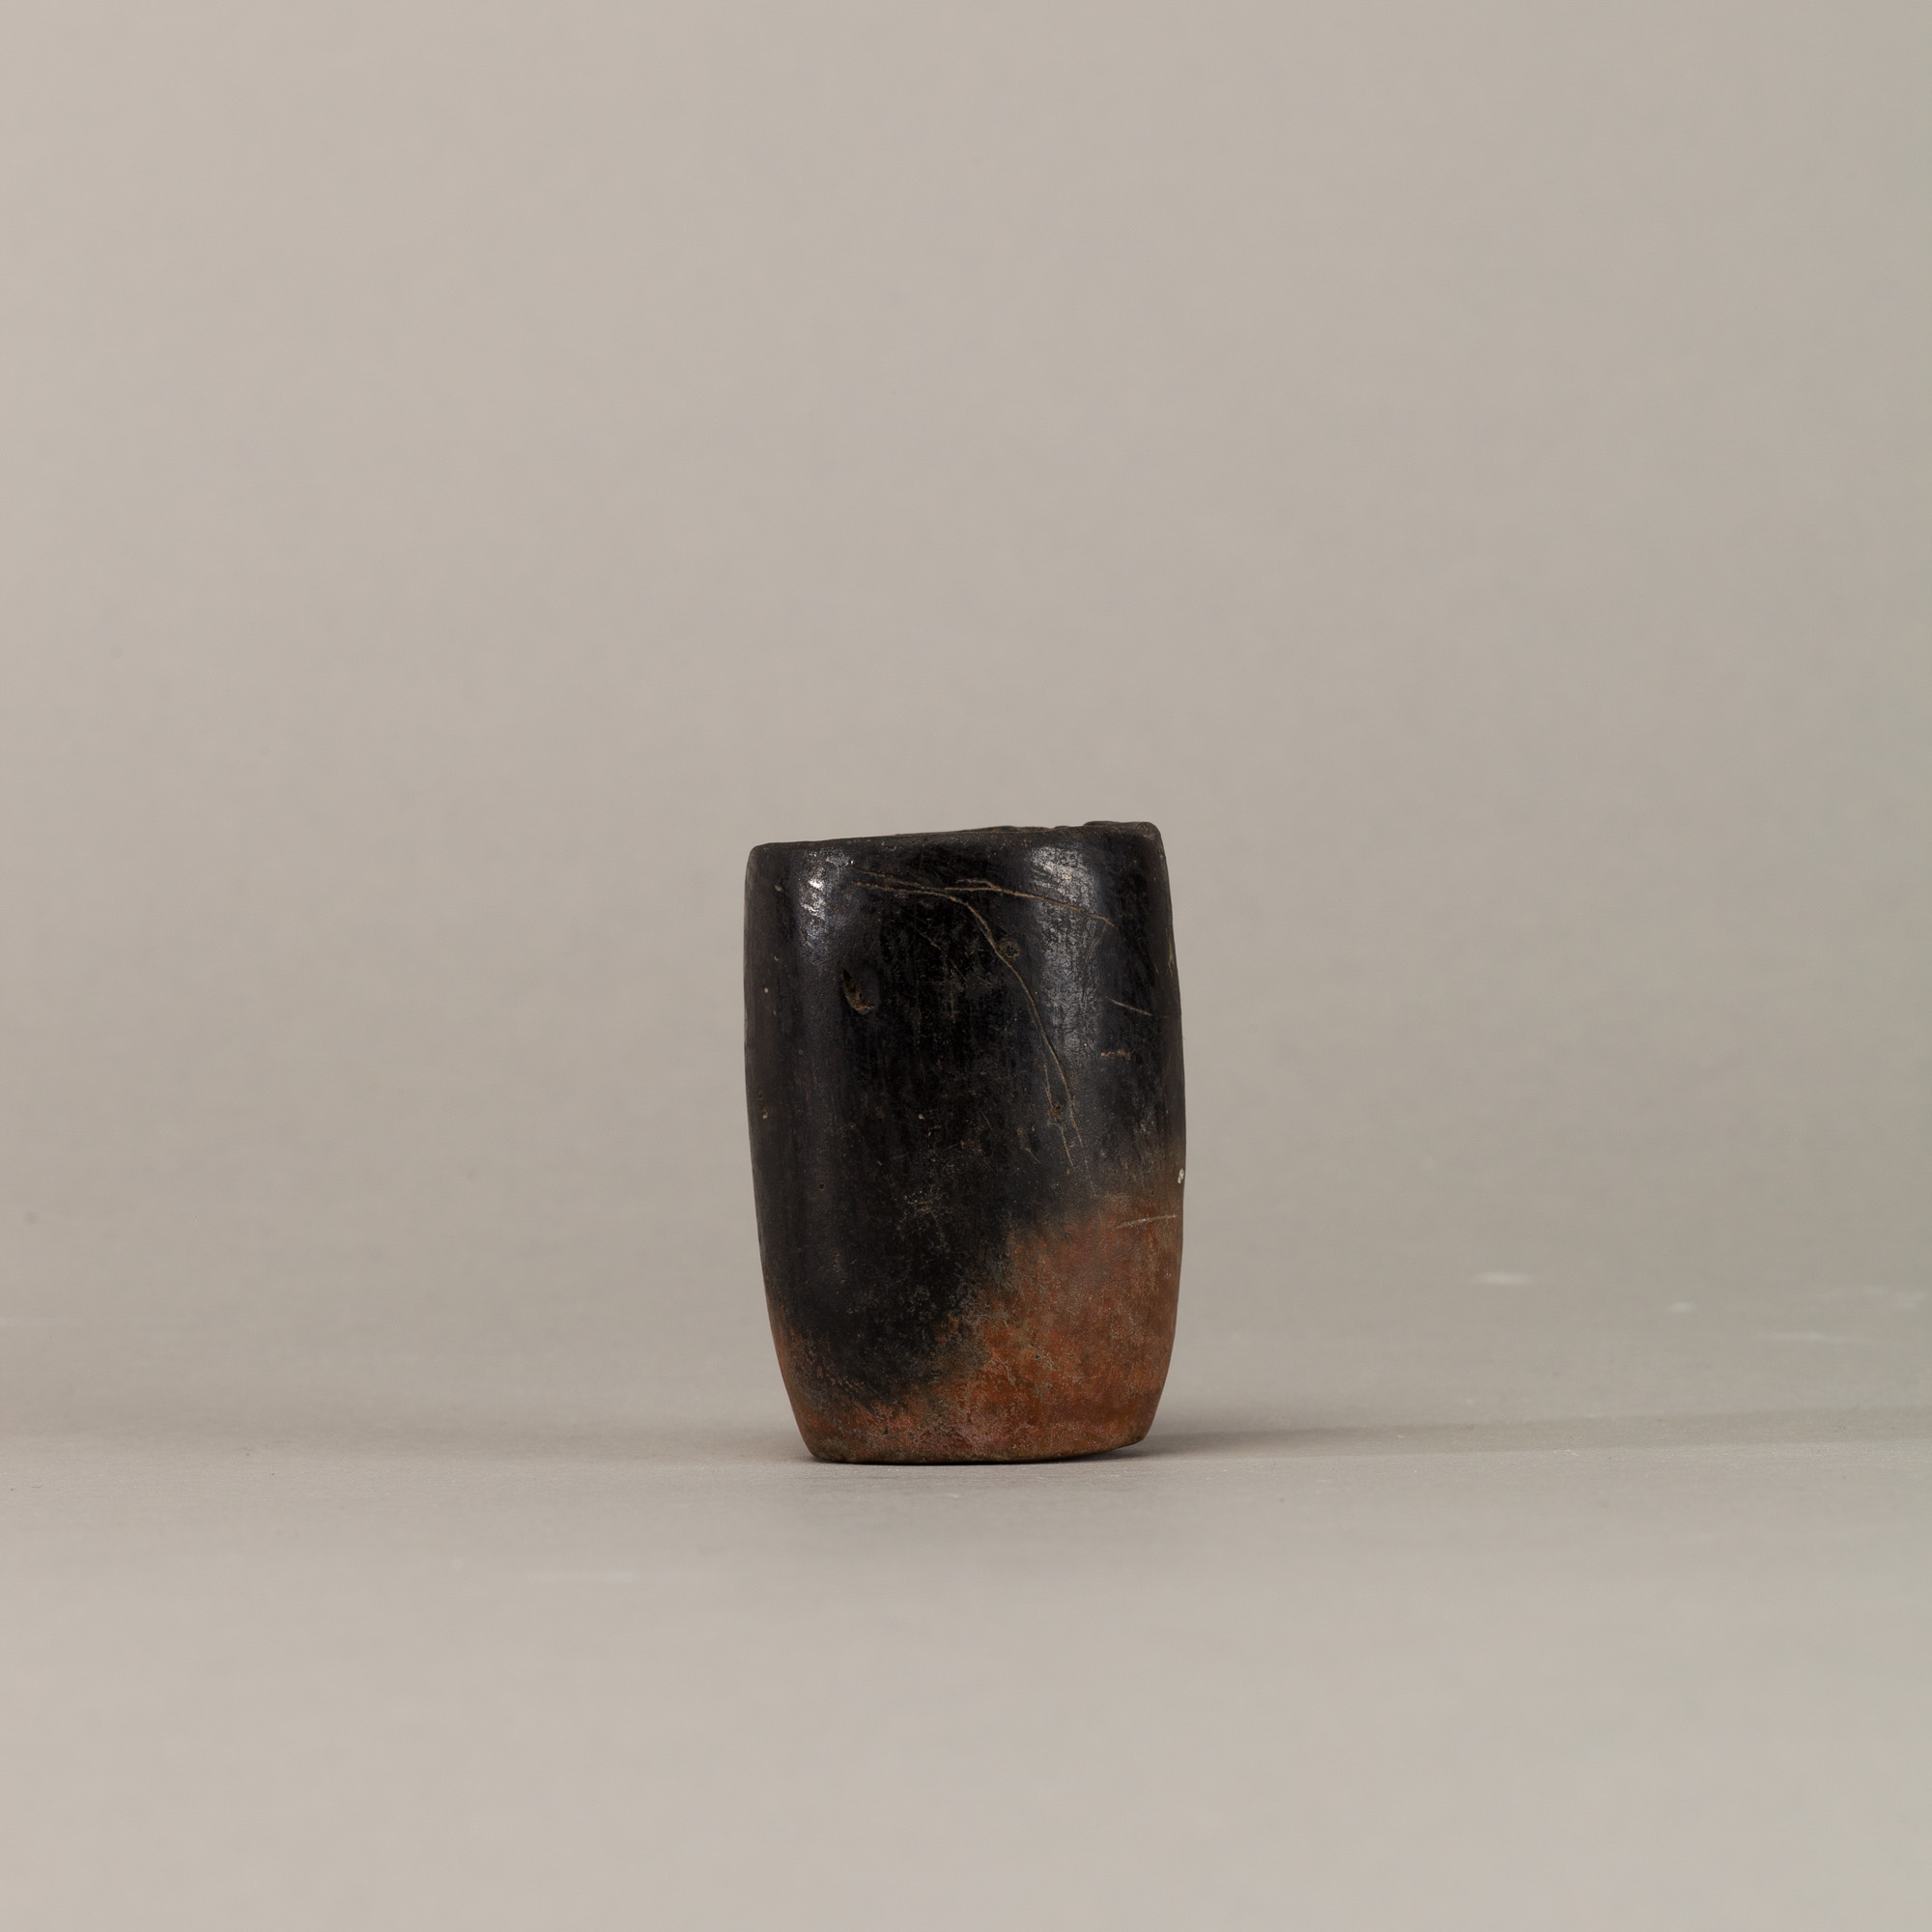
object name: jar, black topped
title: Black-topped red ware cylindrical jar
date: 3850-2960 BCE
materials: pottery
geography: egypt